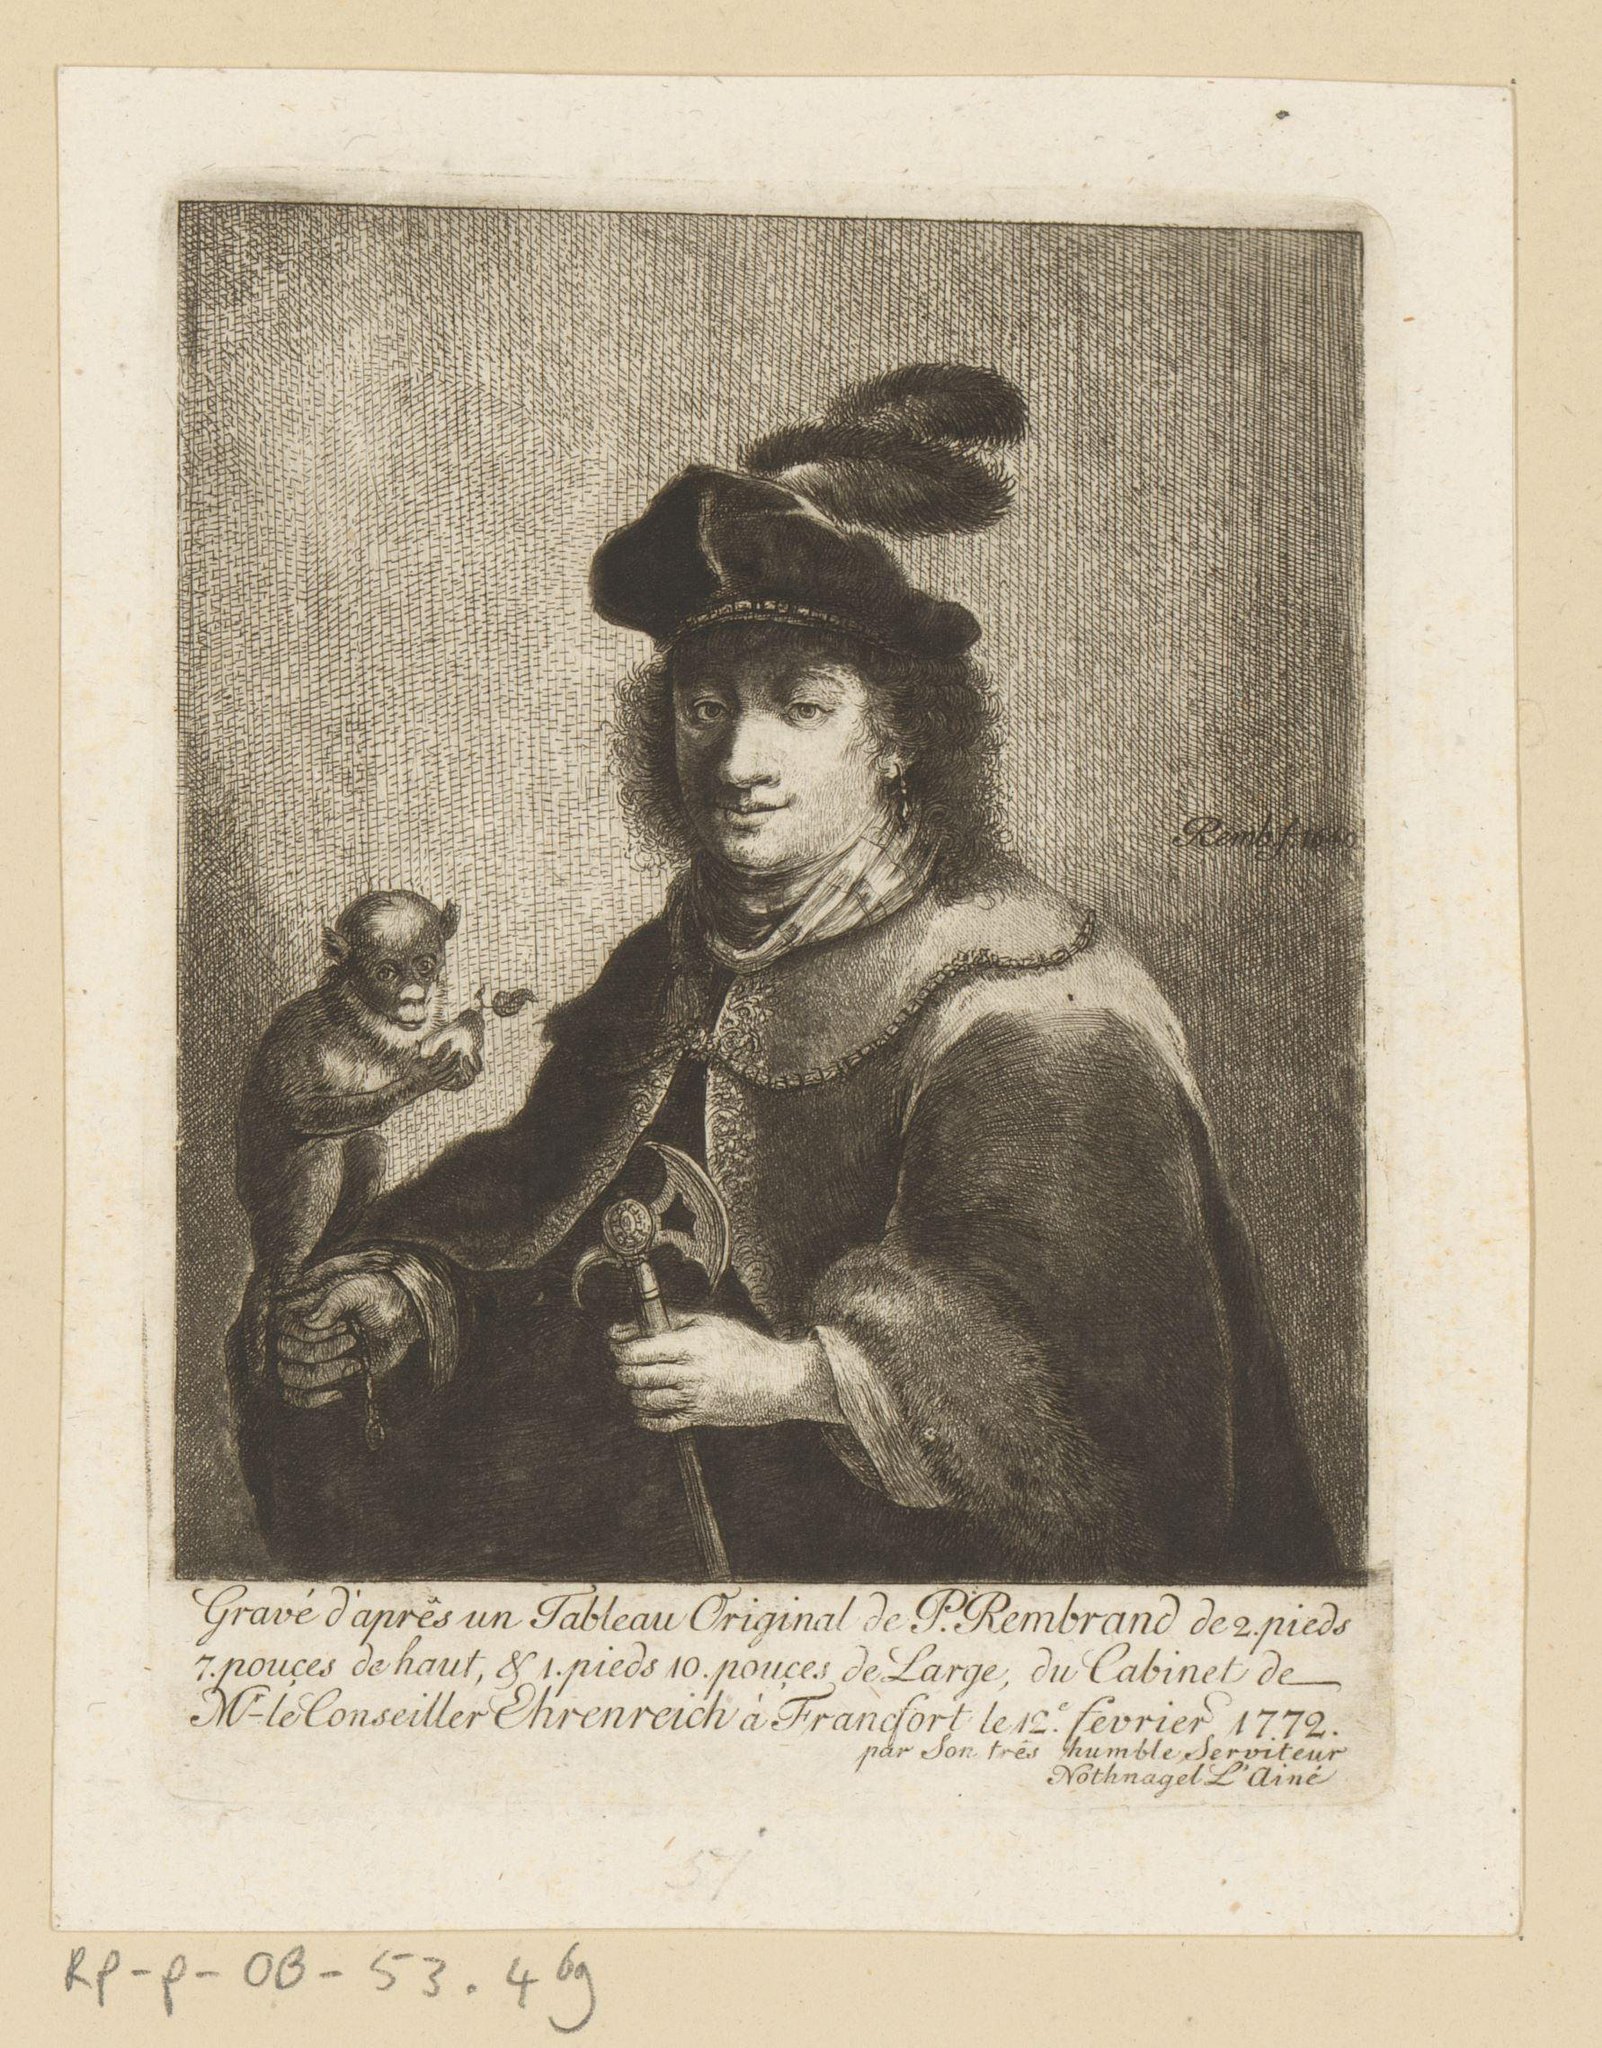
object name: print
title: Man met aap en bijl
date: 1772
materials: paper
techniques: drypoint, etching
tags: monkeys, apes, fruits: pear, adult man, tools, aids, implements ~ crafts and industries: axe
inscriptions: collector's mark: Lugt 2228, collector's mark: Lugt 240